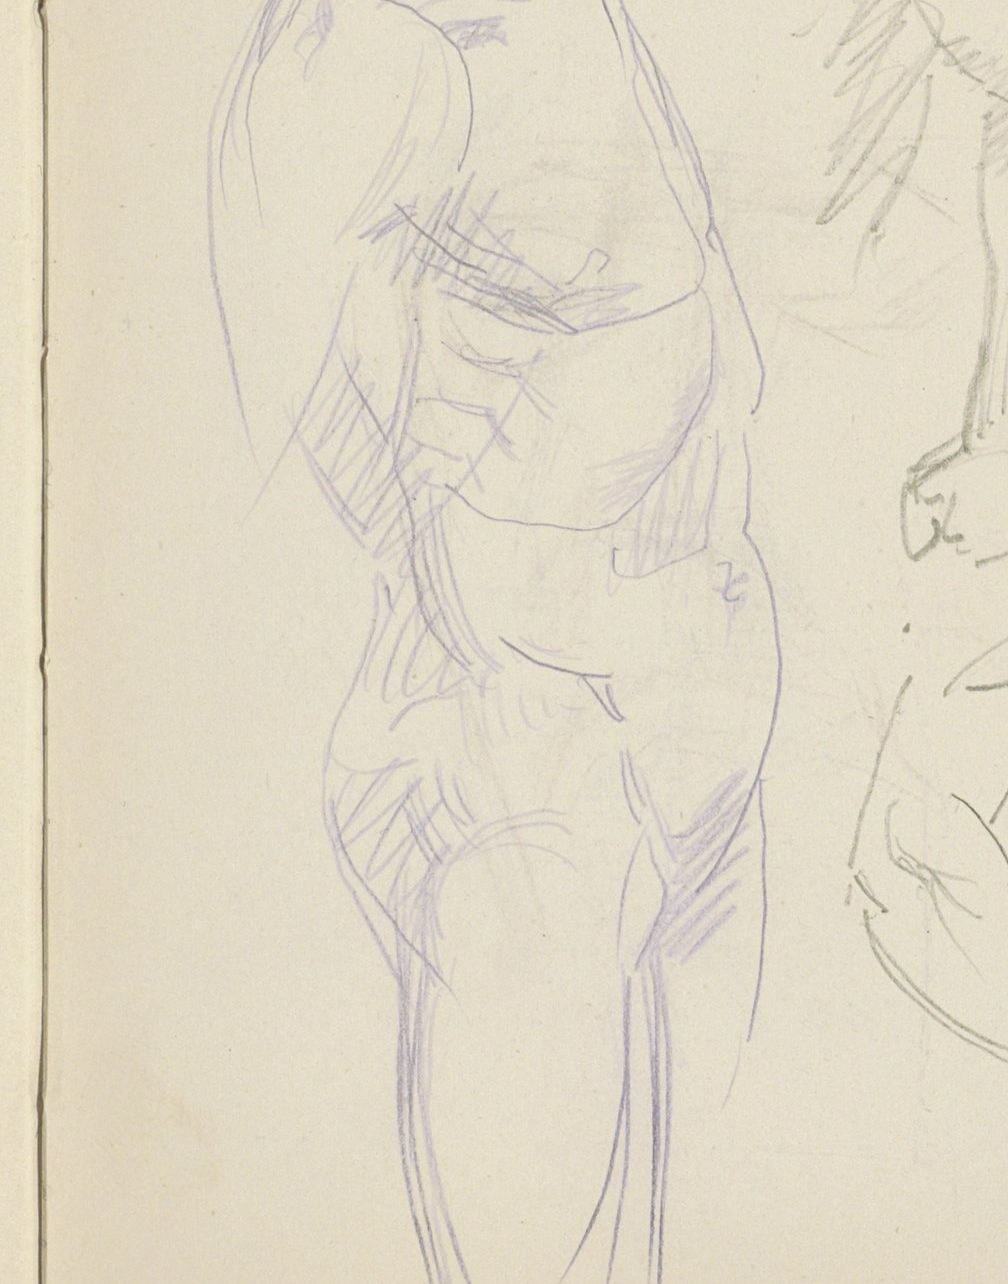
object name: sketchbook leaf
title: Torso van een naakte man en armen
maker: reijer stolk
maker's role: draughtsman, print maker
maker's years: 1896-1945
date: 1906-1945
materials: paper, pencil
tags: arms, torso (+ nude human being)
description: Blad 65 recto uit een schetsboek met 69 bladen.